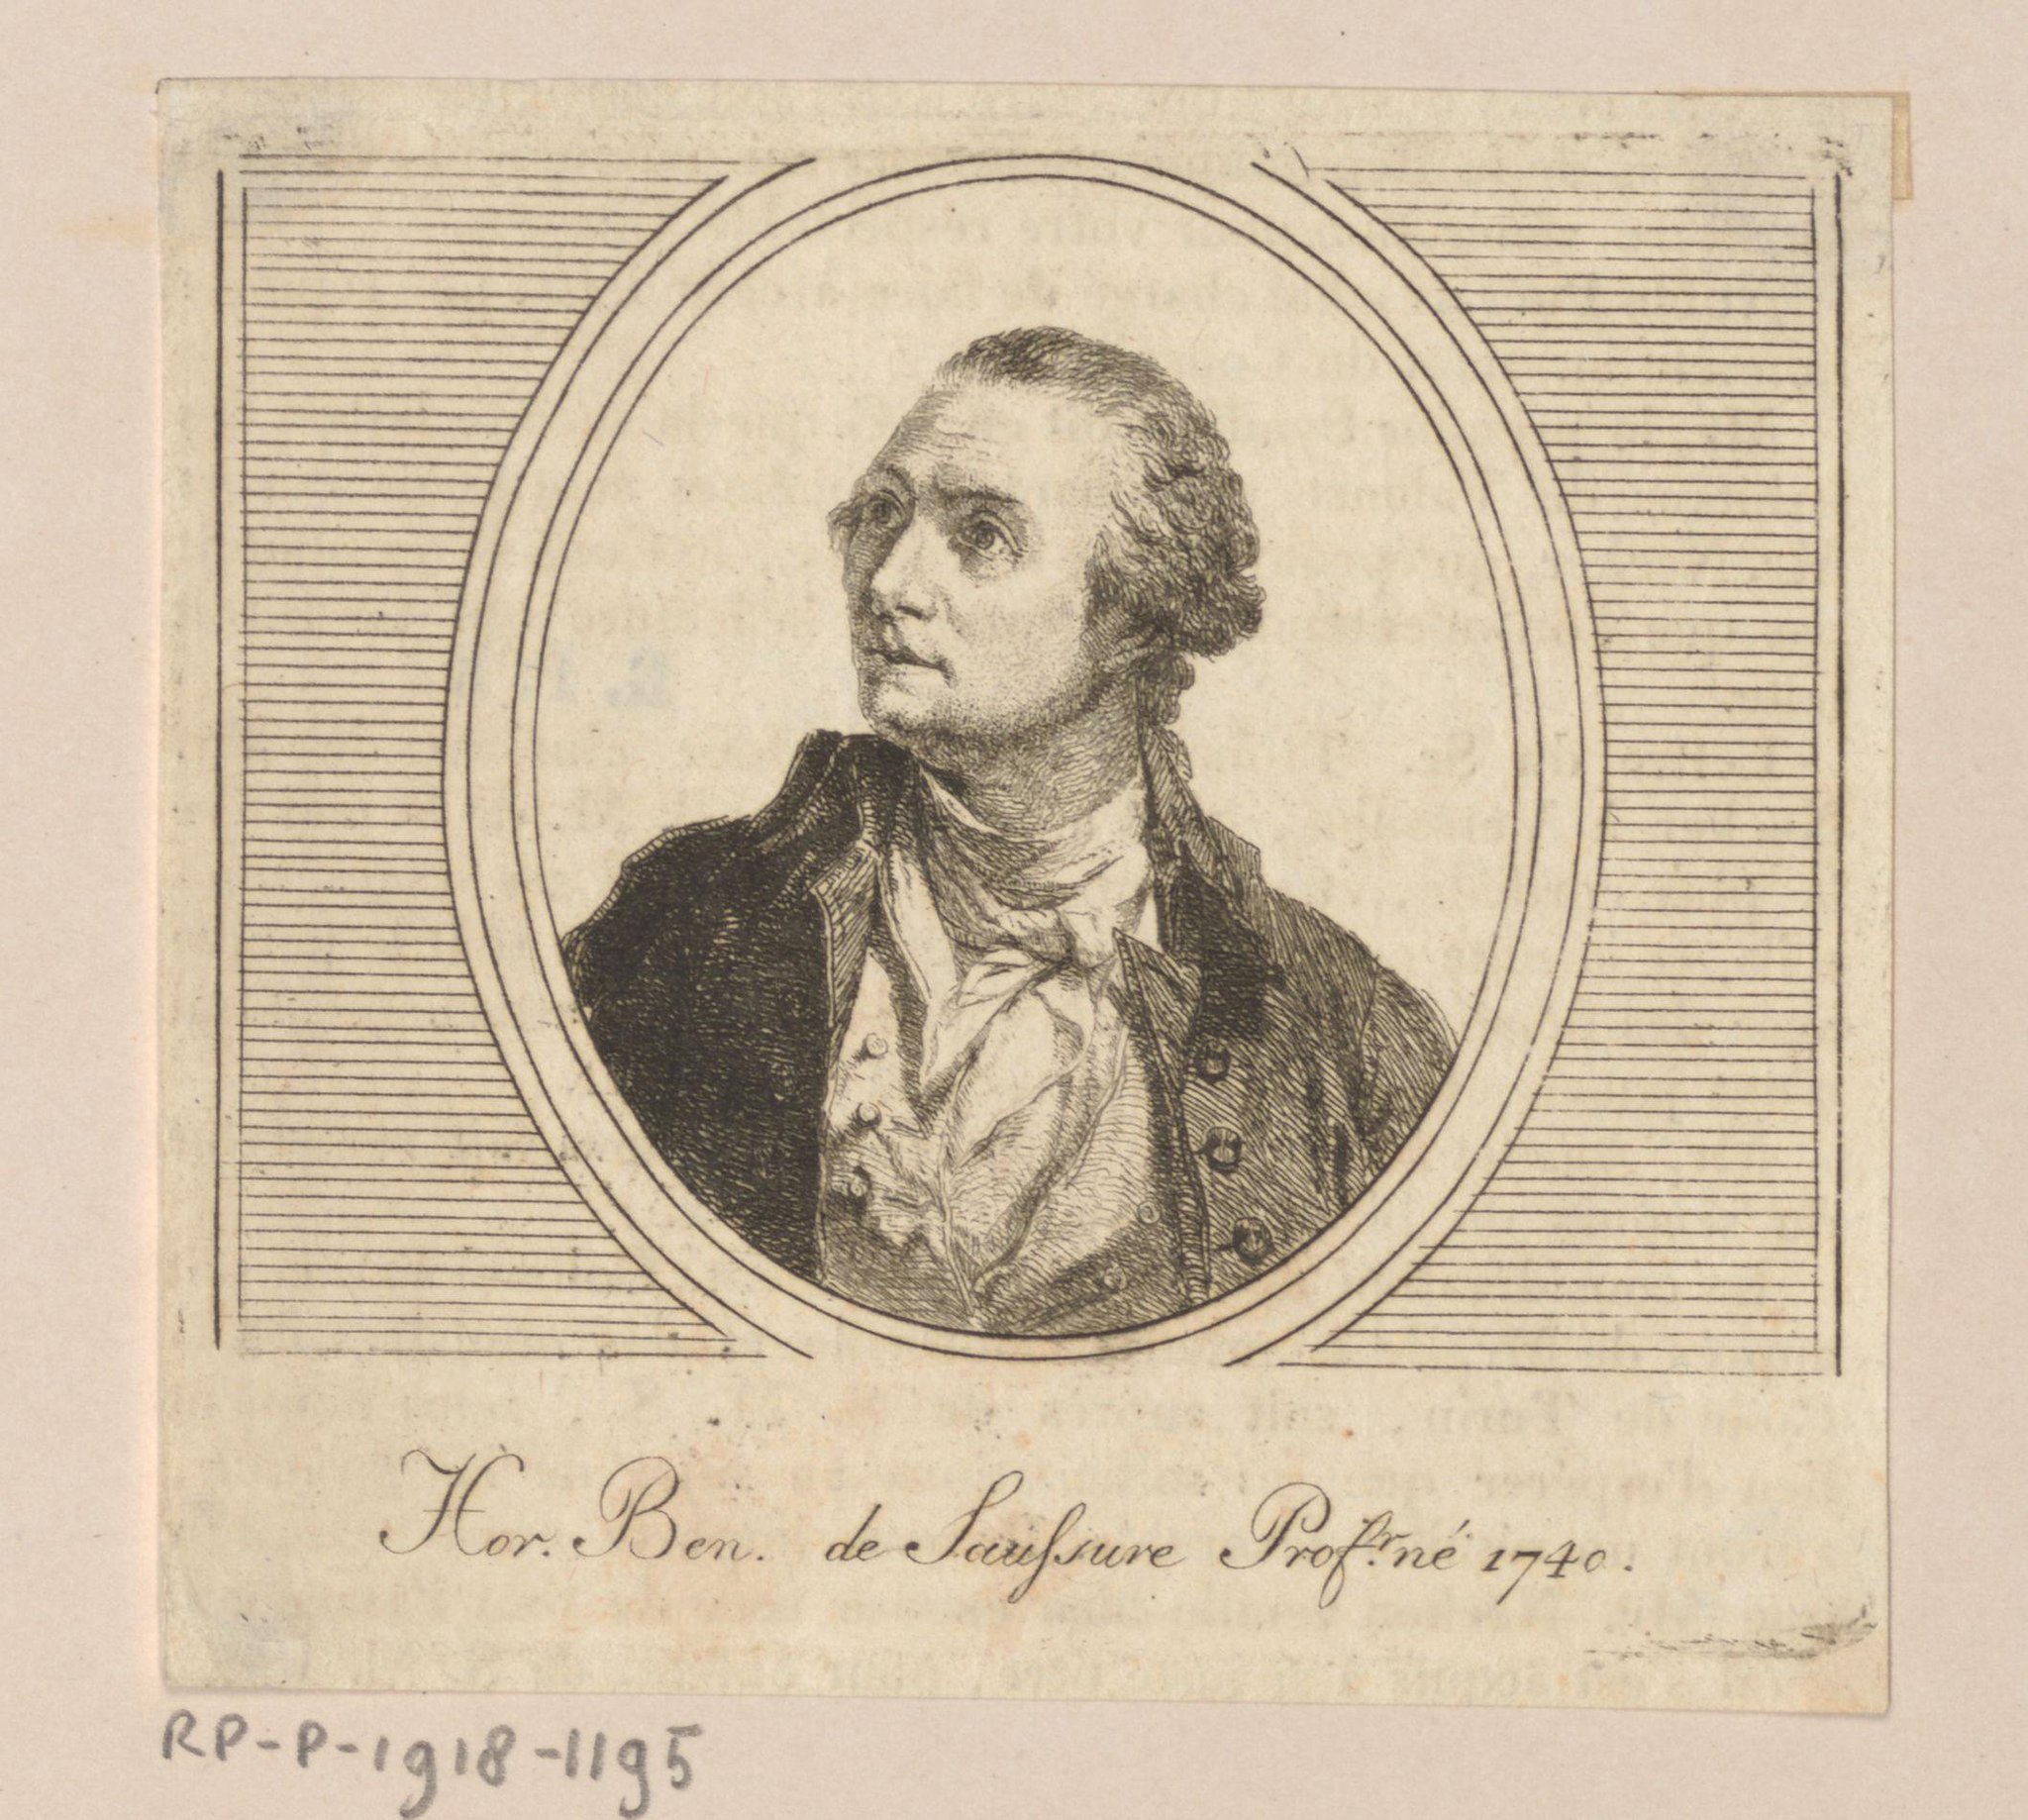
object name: book illustration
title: Portret van Horace-Bénédict de Saussure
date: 1815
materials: paper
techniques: etching, letterpress printing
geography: geneva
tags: physicist, science and technology, historical persons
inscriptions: collector's mark: Lugt 2233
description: Prent uit: Grenus, Théodore de. Fragmens biographiques et historiques. Extraits des registres du Conseil (...). Genève: Manget et Cherbuliez, 1815.